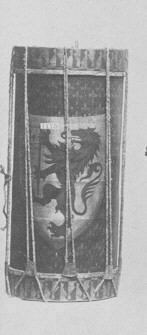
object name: drum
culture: italian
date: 1601-1700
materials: cord, skin, wood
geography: italy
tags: coat of arms